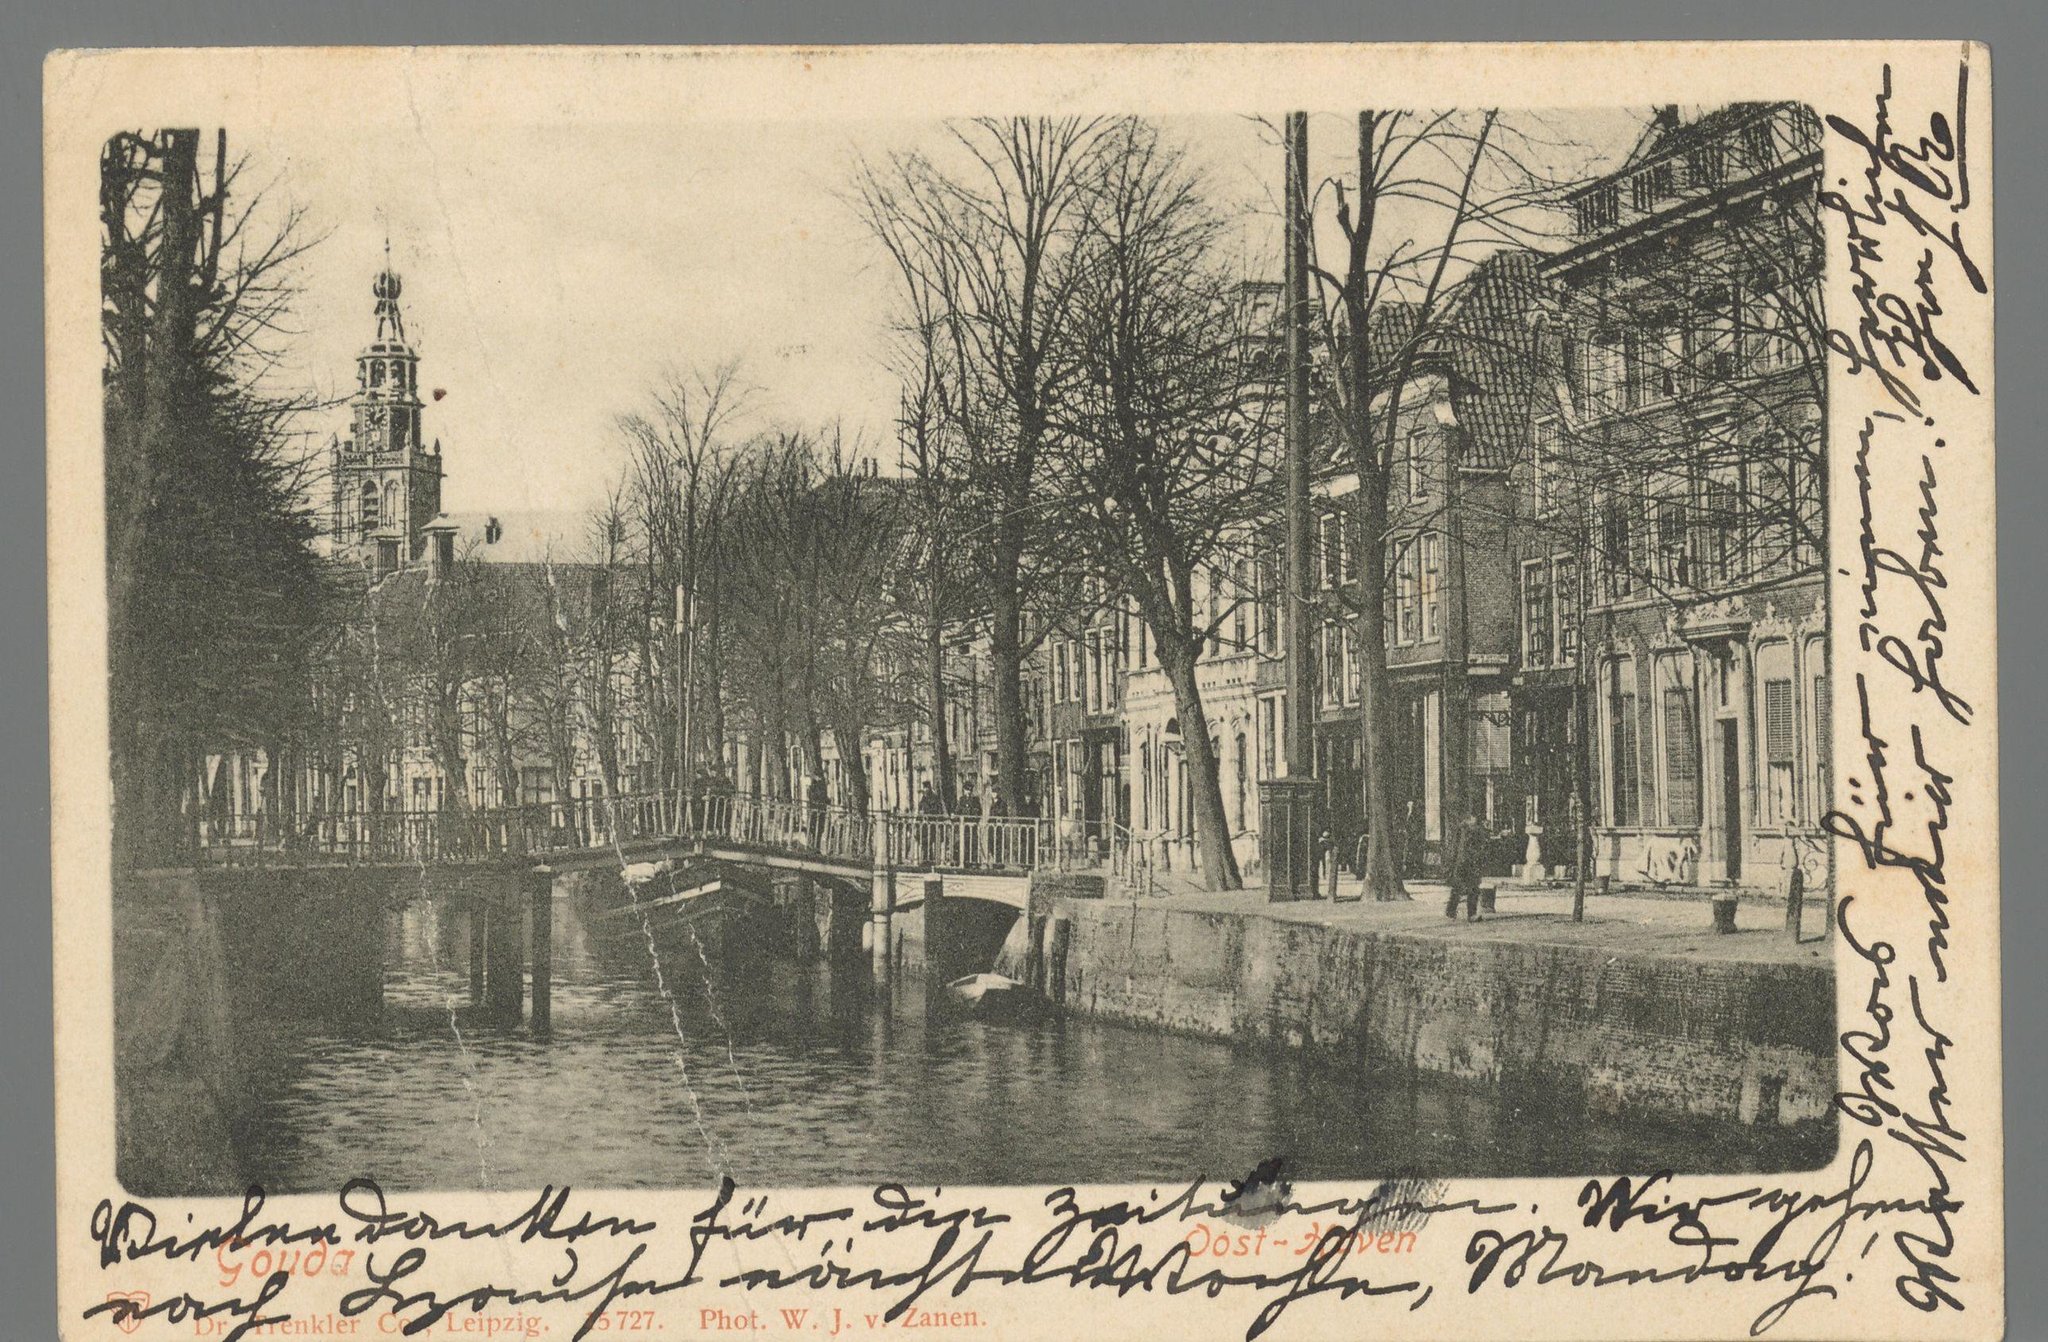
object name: ansichtkaart, prentbriefkaart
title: Gouda. Oost-Haven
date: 1894-1904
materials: cardboard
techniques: photograph, writing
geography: gouda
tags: canal, church (exterior), street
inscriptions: postage stamp